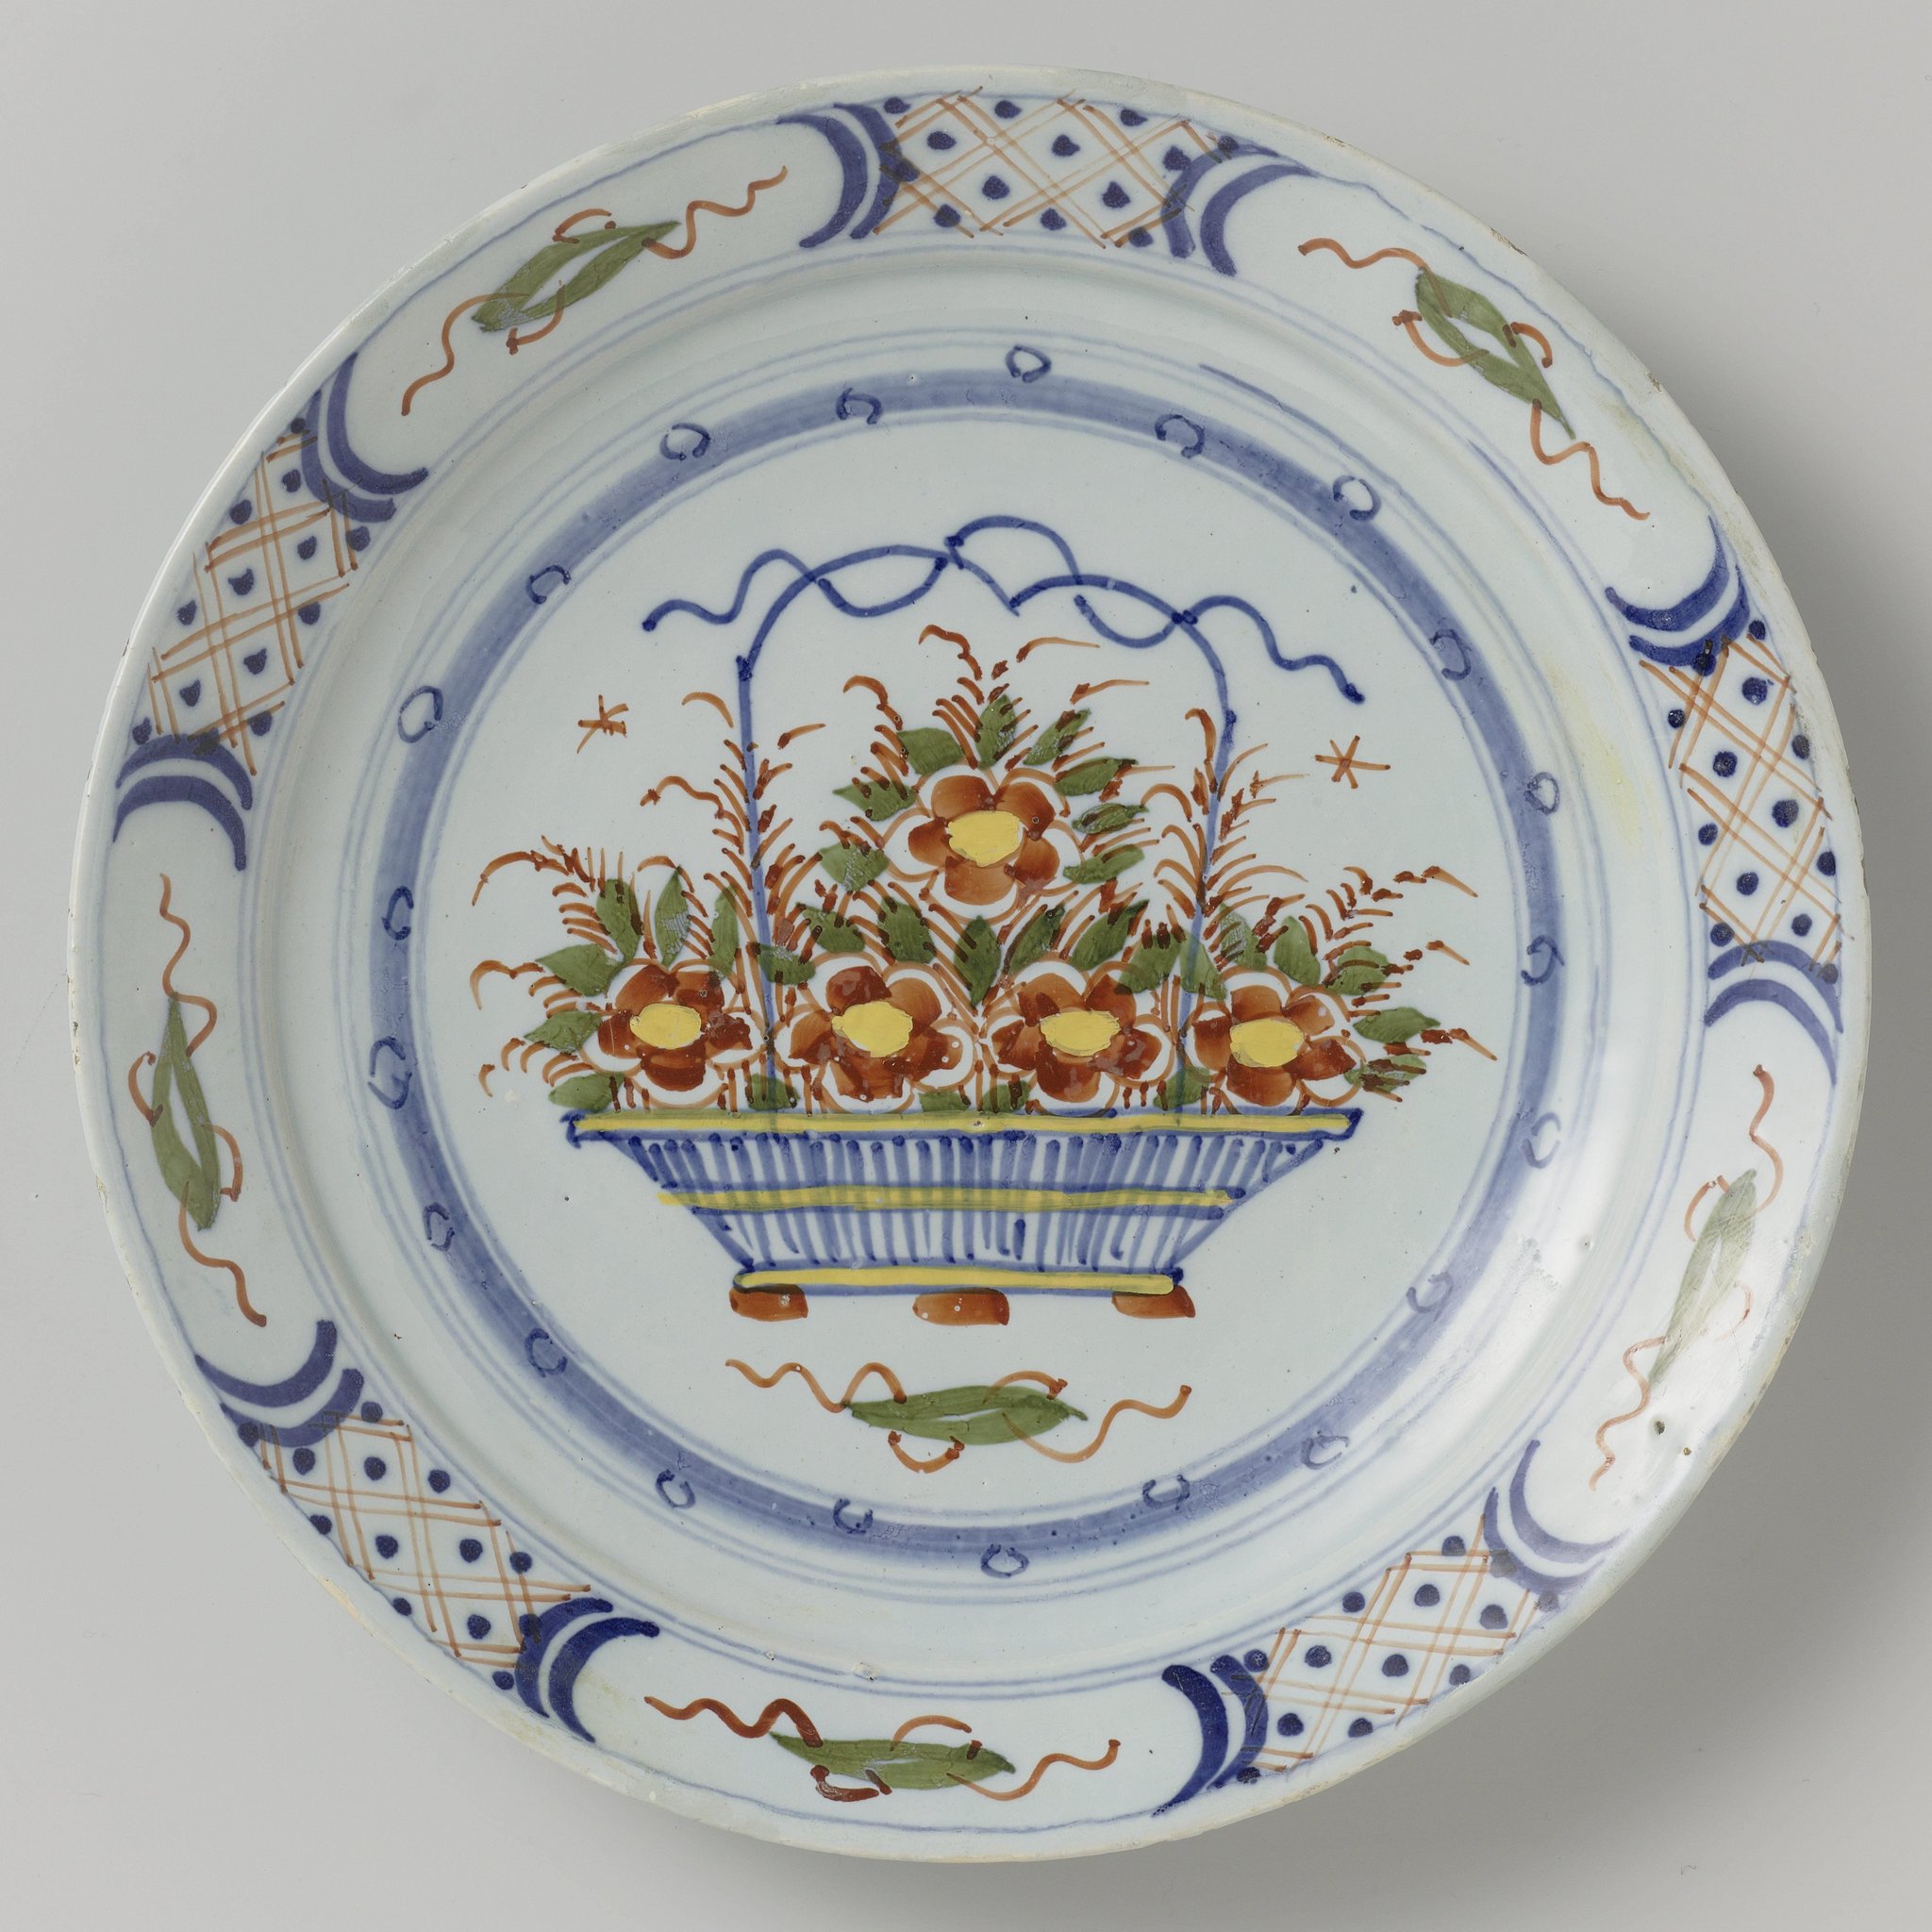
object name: plate dish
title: bord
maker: Anonymous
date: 1740-1780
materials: earthenware, glaze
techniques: painted, polychromy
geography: delft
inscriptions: collector's mark: ‘koninklijk oudheidkundig genootschap no. 46’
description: Rond bord van veelkleurig beschilderde faience, met op het plat een mand met bloemen in de kleuren blauw, groen, geel en rood en op de rand een veelkleurig Chinees motief. Bij het bord horen vier identieke borden met de invnrs. BK-KOG-2428-a, BK-KOG-2428-b, BK-KOG-2428-c en BK-KOG-2428-e.